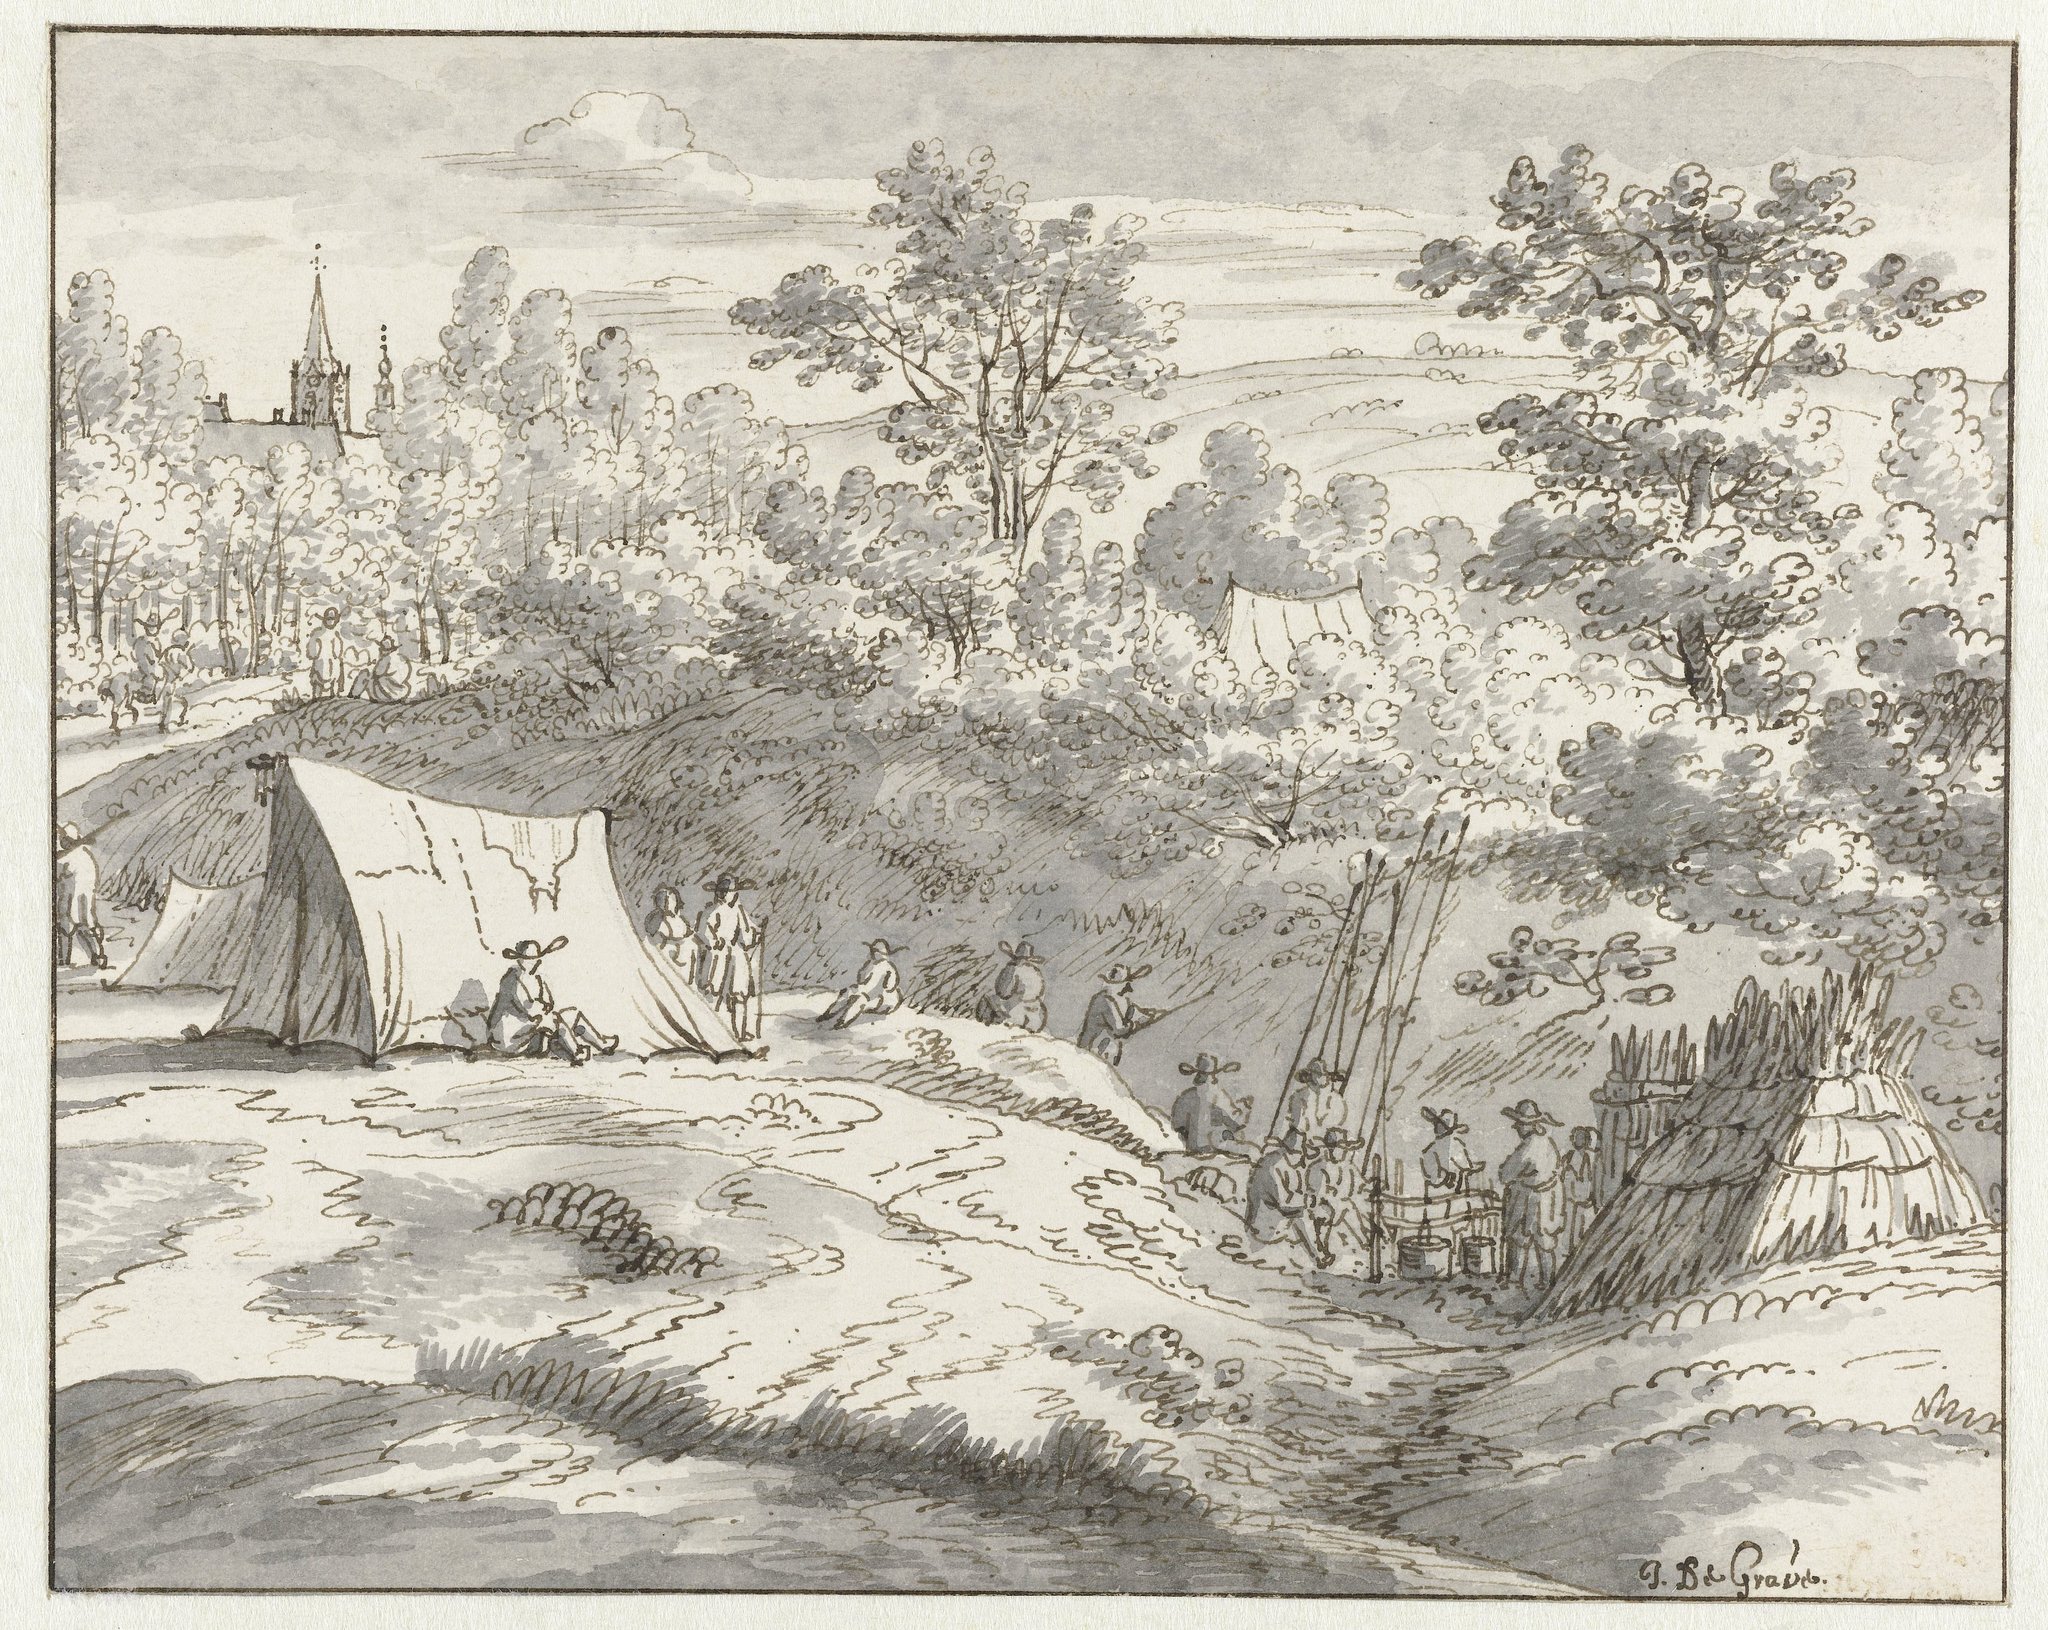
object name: drawing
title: View of an Encampment of the Army of Willem III near Limal, Walloon Brabant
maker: josua de grave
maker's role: draughtsman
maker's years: 1645-1712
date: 1675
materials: ink, paper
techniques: brush, pen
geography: henegouwen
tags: william iii (prince of orange and king of england, scotland, and ireland), (military) camp with tents, henegouwen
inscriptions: date: ‘1675’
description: Kampement van het leger van Willem III in Henegouwen bij het dorp Limal, 1675. Rustende soldaten bij tenten.